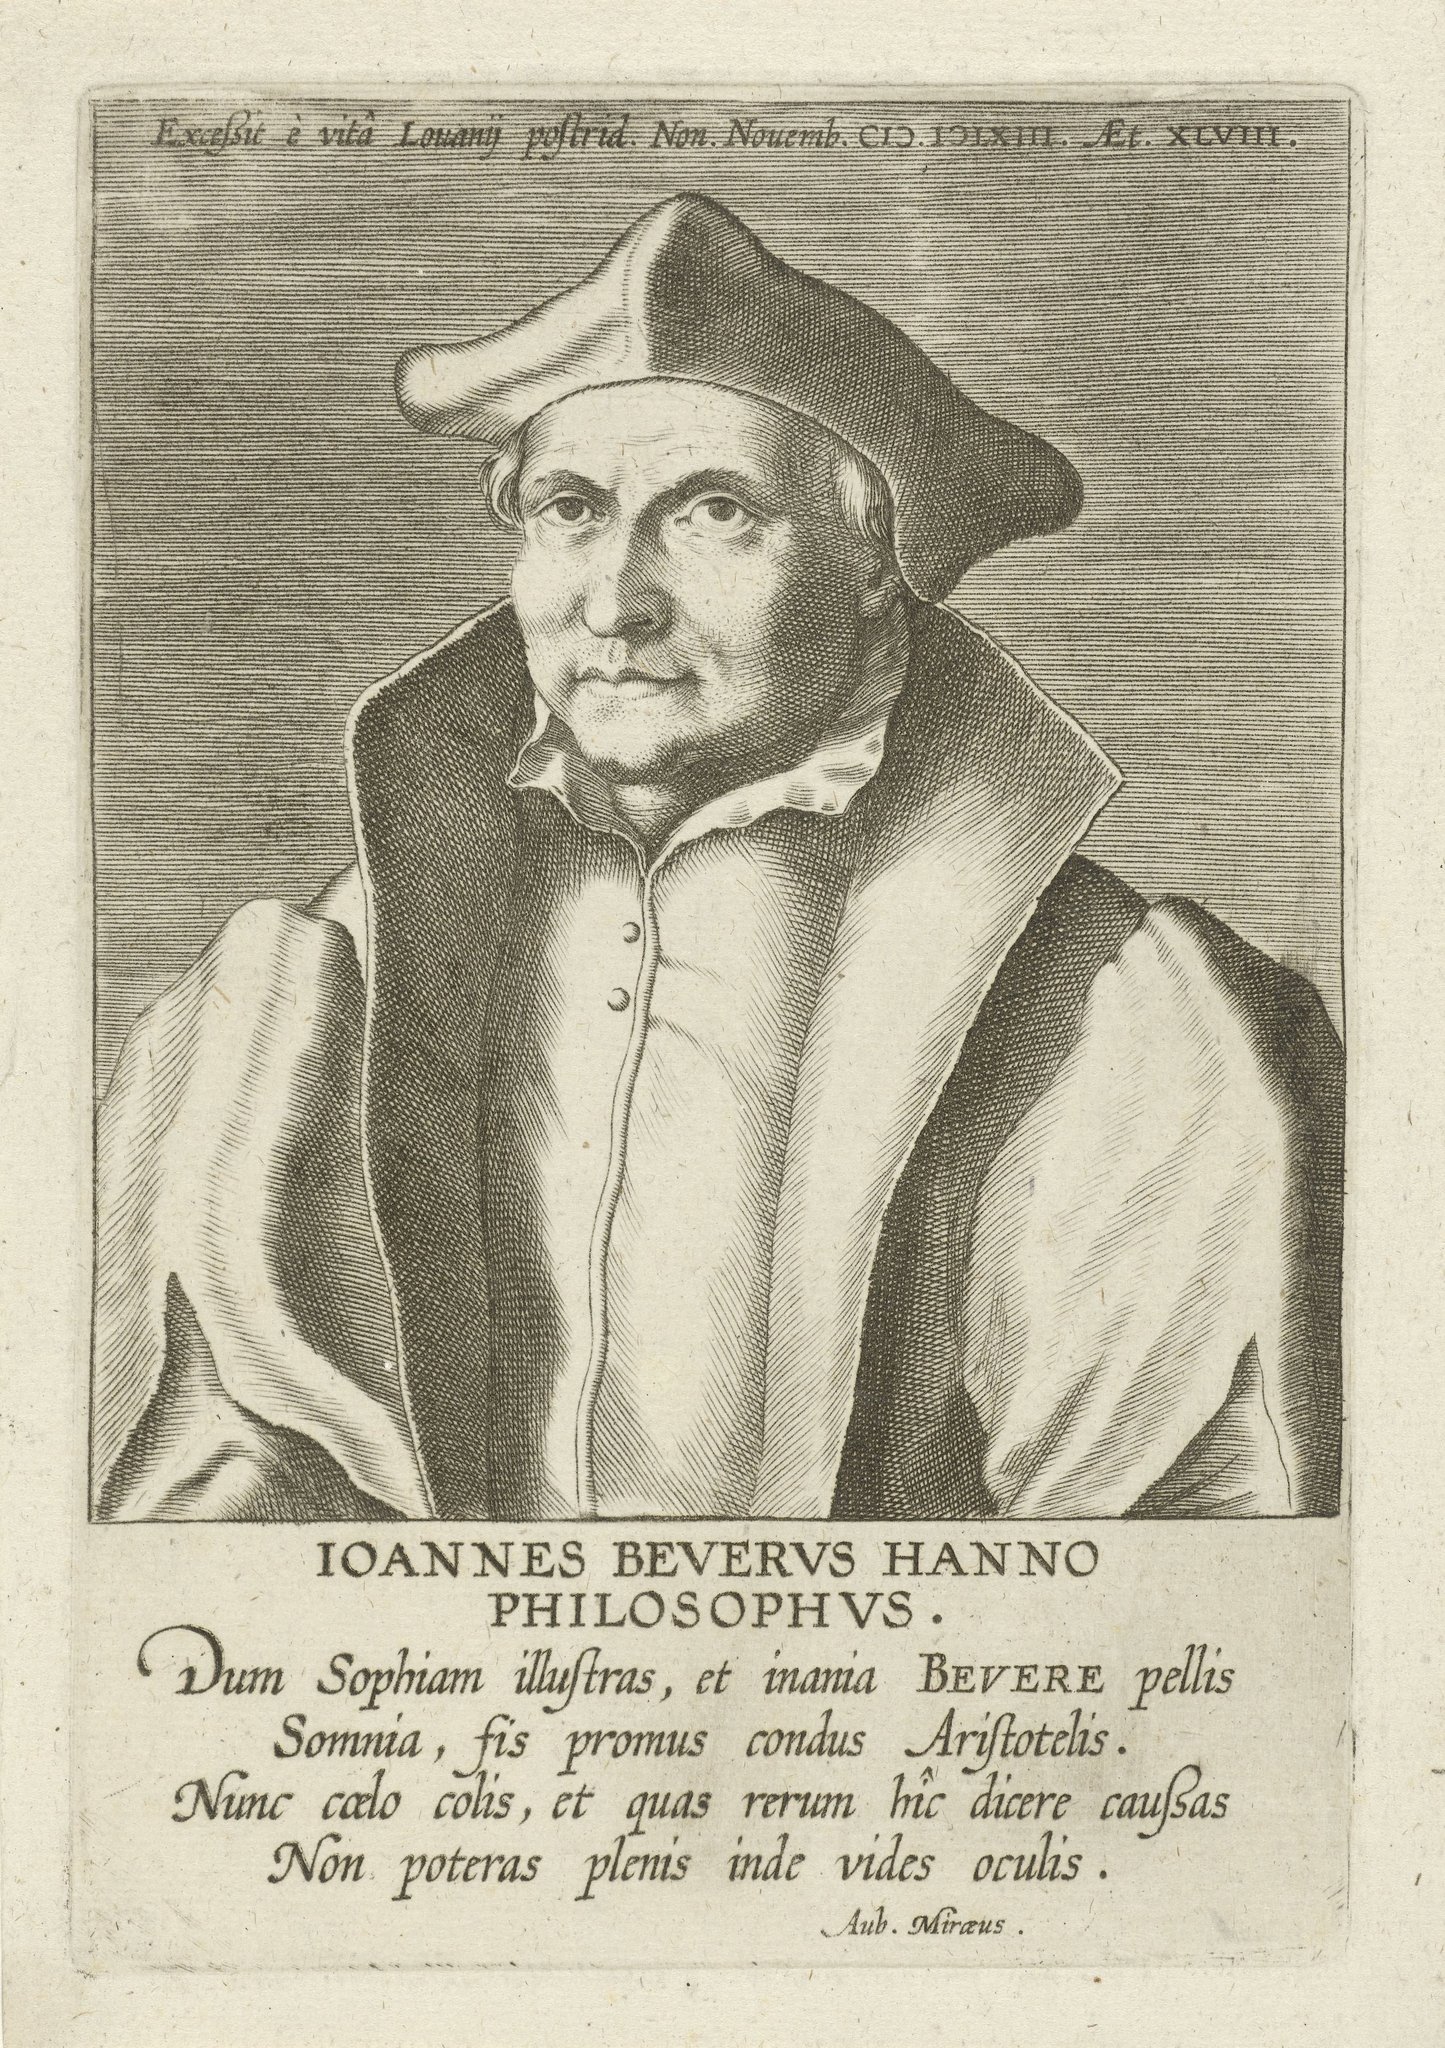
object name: book illustration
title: Portret van Johannes Beverus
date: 1604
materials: paper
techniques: engraving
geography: brussels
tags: louvain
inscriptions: collector's mark: Lugt 2228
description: Portret van Johannes Beverus, professor filosofie in Leuven. Buste licht naar links. De prent heeft een Latijns boven- en onderschrift en maakt deel uit van een serie van beroemde Nederlandse en Vlaamse geleerden.